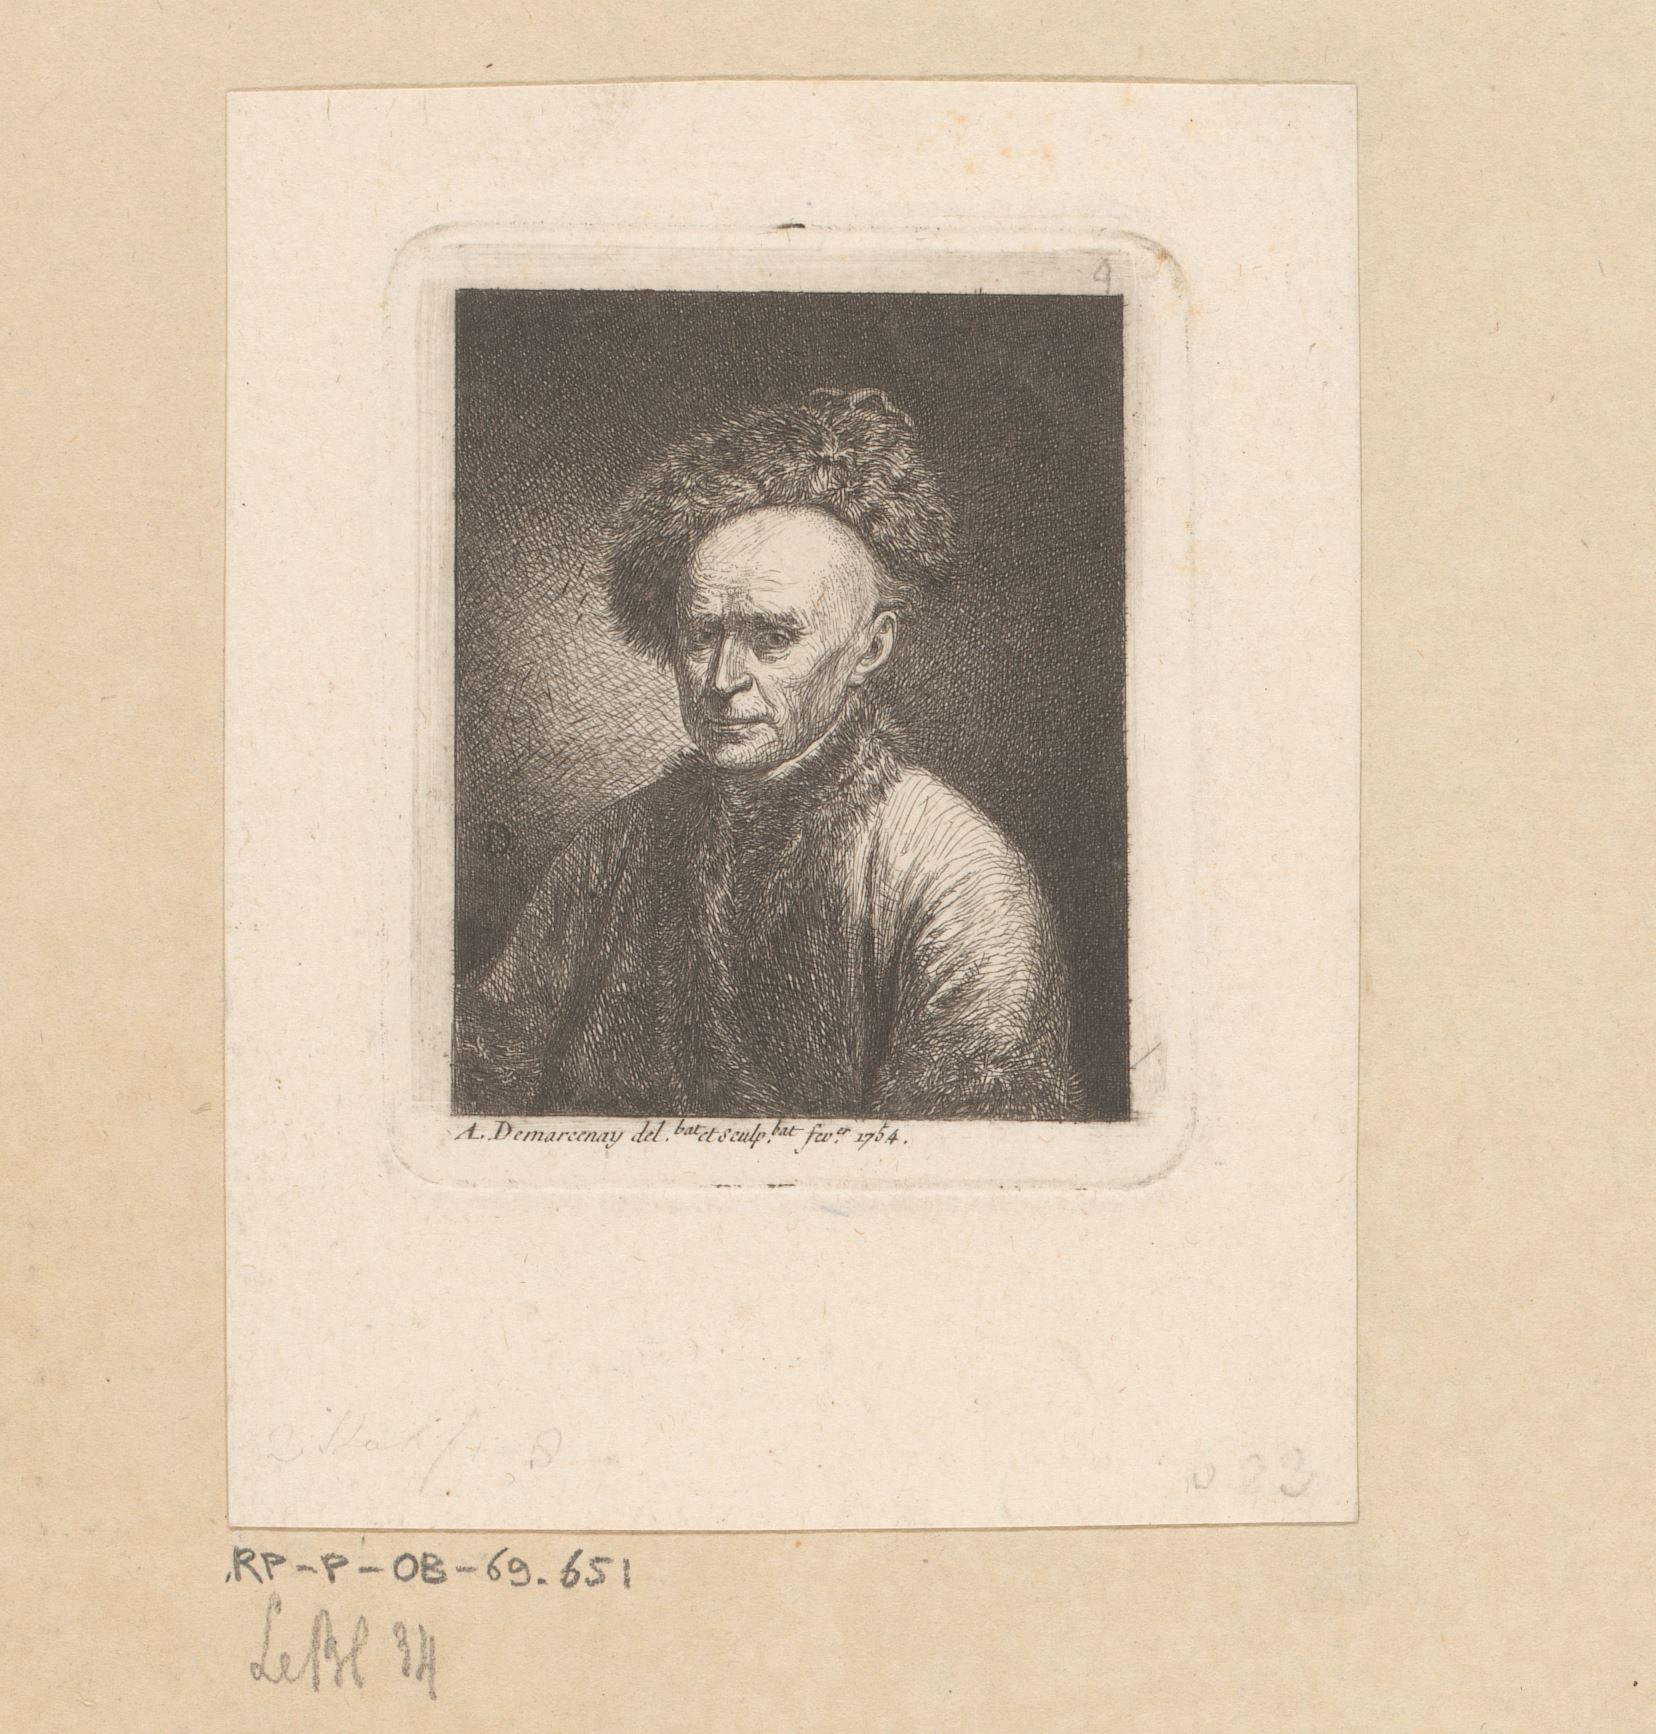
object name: print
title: Man met bontmuts en bontkraag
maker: antoine de marcenay de ghuy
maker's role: print maker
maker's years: 1724-1811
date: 1702-1754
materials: paper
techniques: etching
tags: head-gear (with name)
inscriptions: collector's mark: Lugt 240